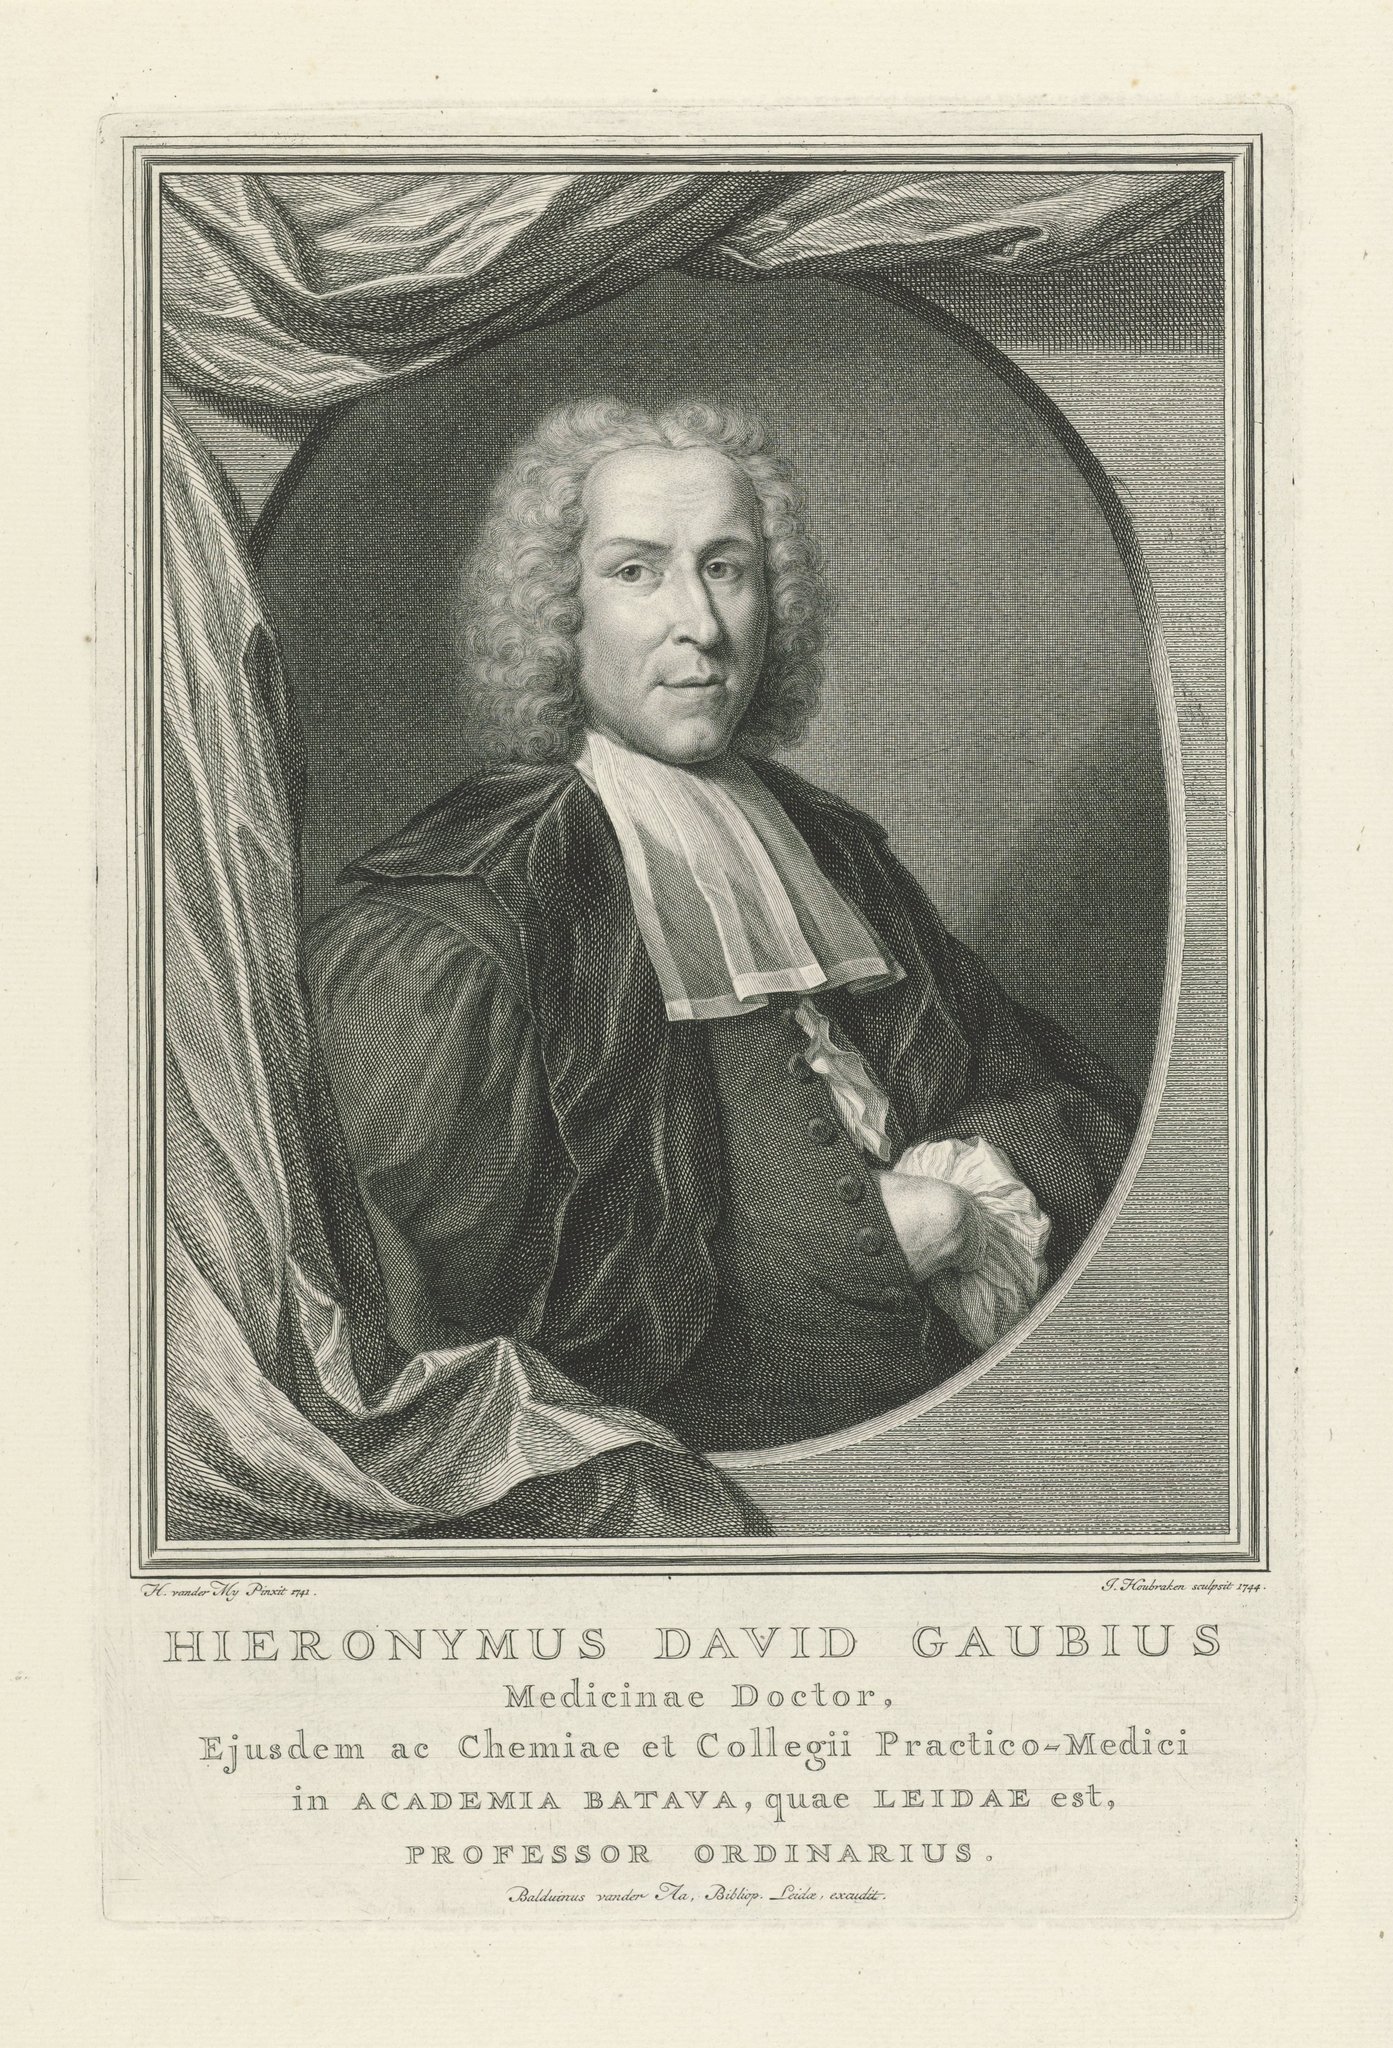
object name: print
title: Hieronymus David Gaubius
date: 1744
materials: paper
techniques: engraving, etching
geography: amsterdam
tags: leiden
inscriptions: collector's mark: Lugt 240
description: Portret ten halven lijve naar rechts van Hieronymus David Gaubius in een ovaal met rechts een gordijn. Onder het portret zijn naam en gegevens in zeven regels in het Latijn.